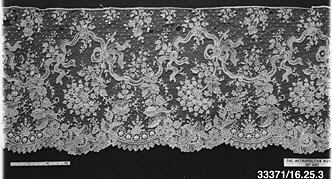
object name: flounce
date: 1801-1900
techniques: lace